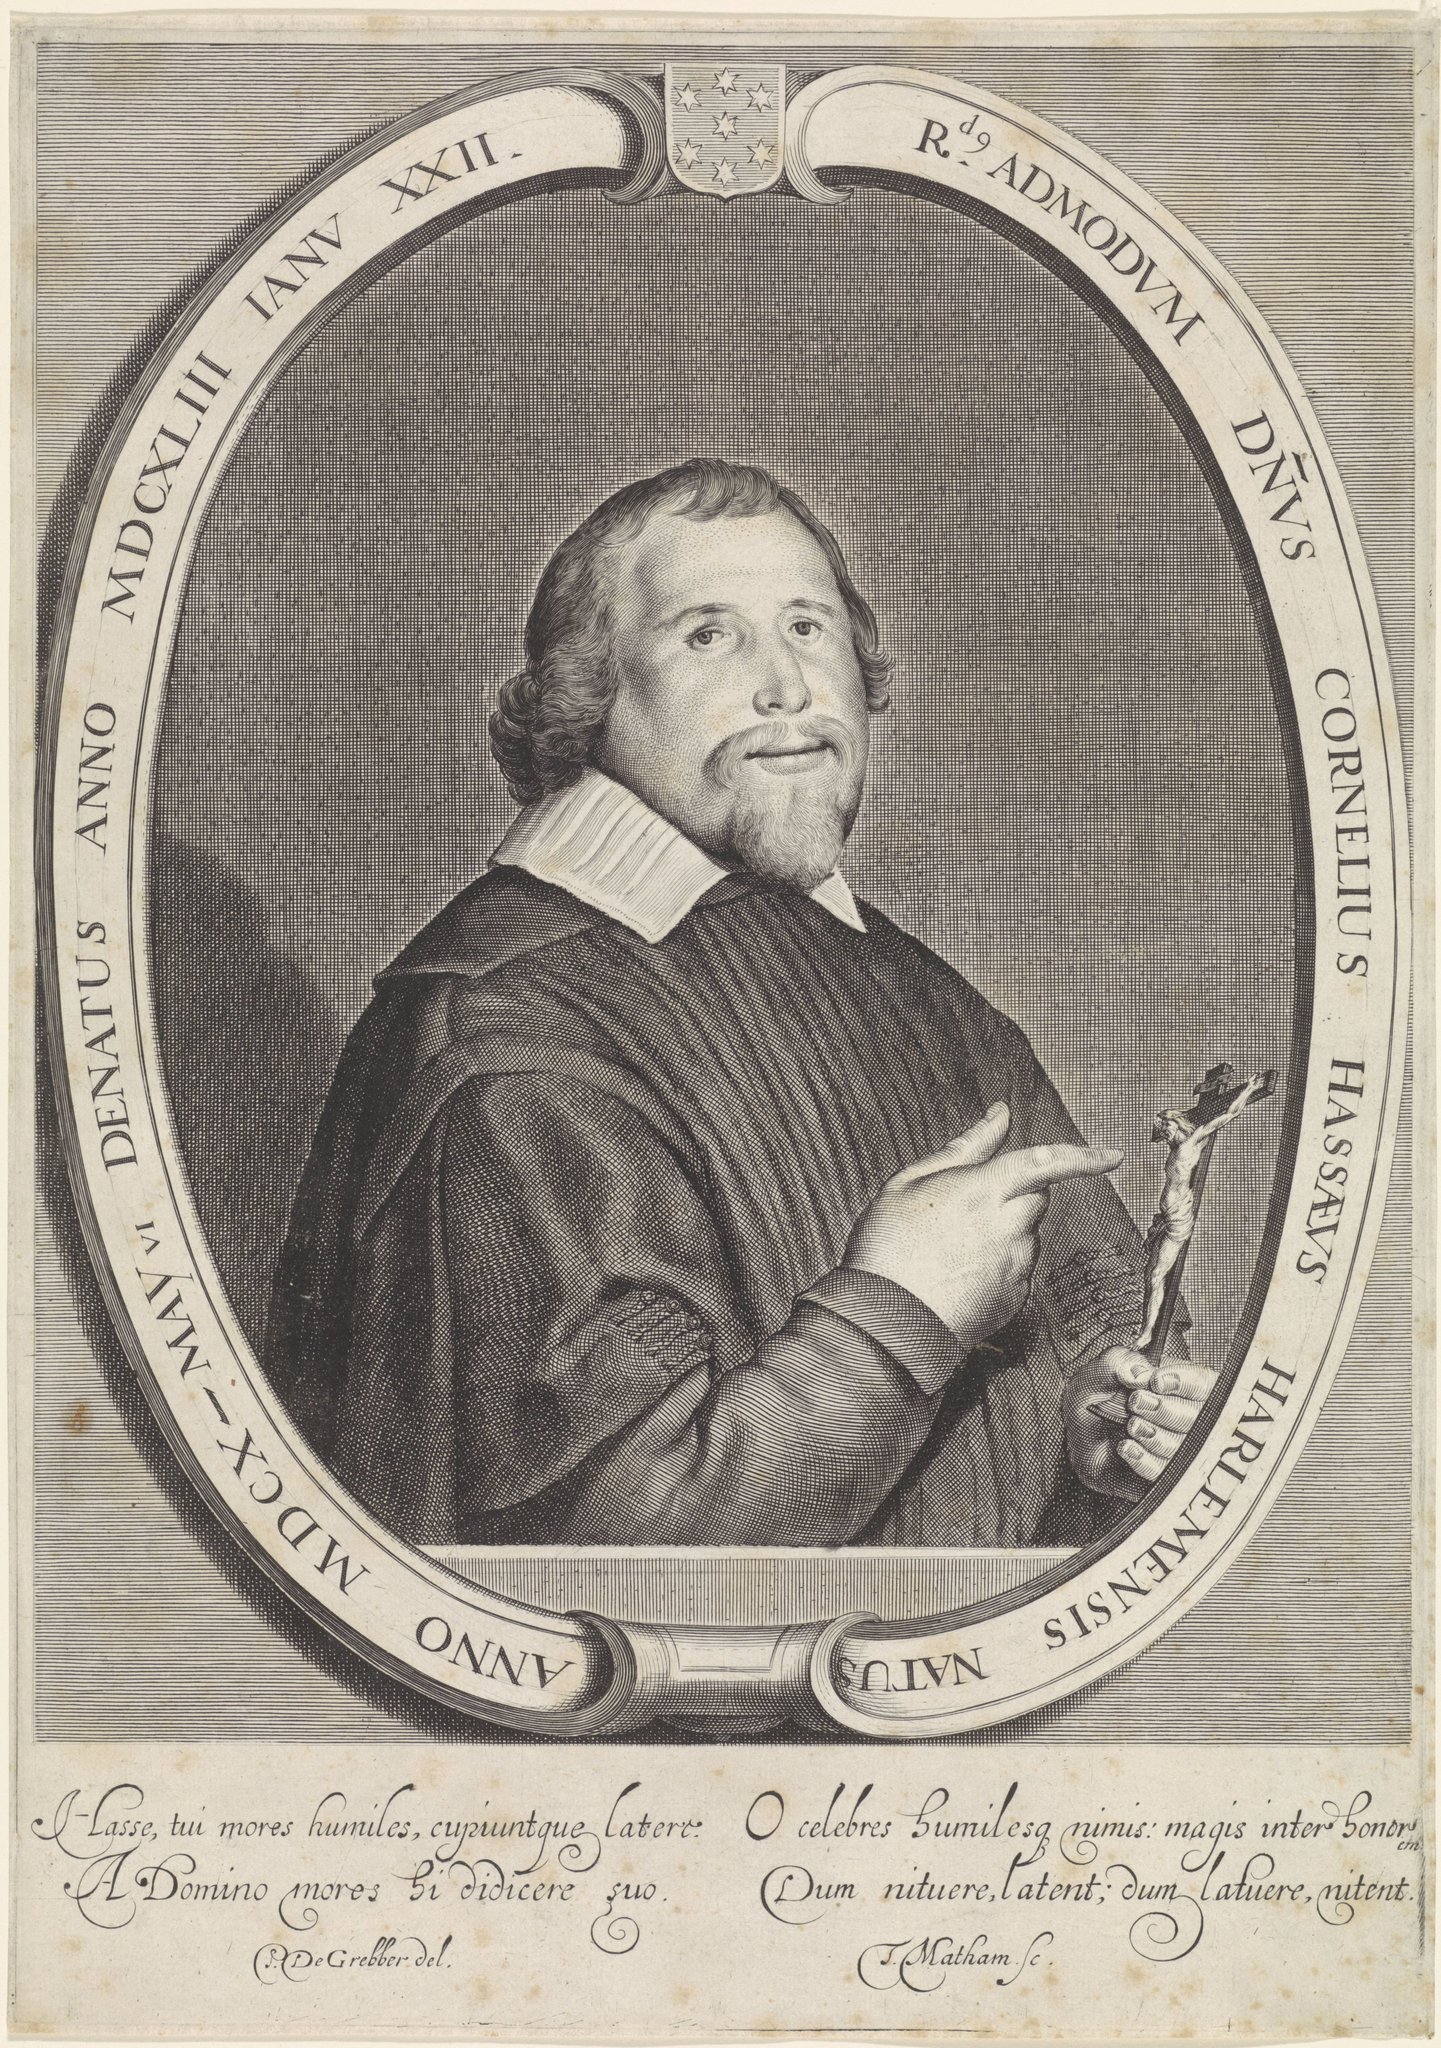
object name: print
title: Portret van Cornelis Hassaeus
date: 1643-1676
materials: paper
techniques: engraving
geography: northern netherlands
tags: crucifix ~ personal devotion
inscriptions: collector's mark: Lugt 2228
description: Portret van de Haarlemse theoloog Cornelis Hassaeus, wijzend op een crucifix dat hij in zijn hand houdt.